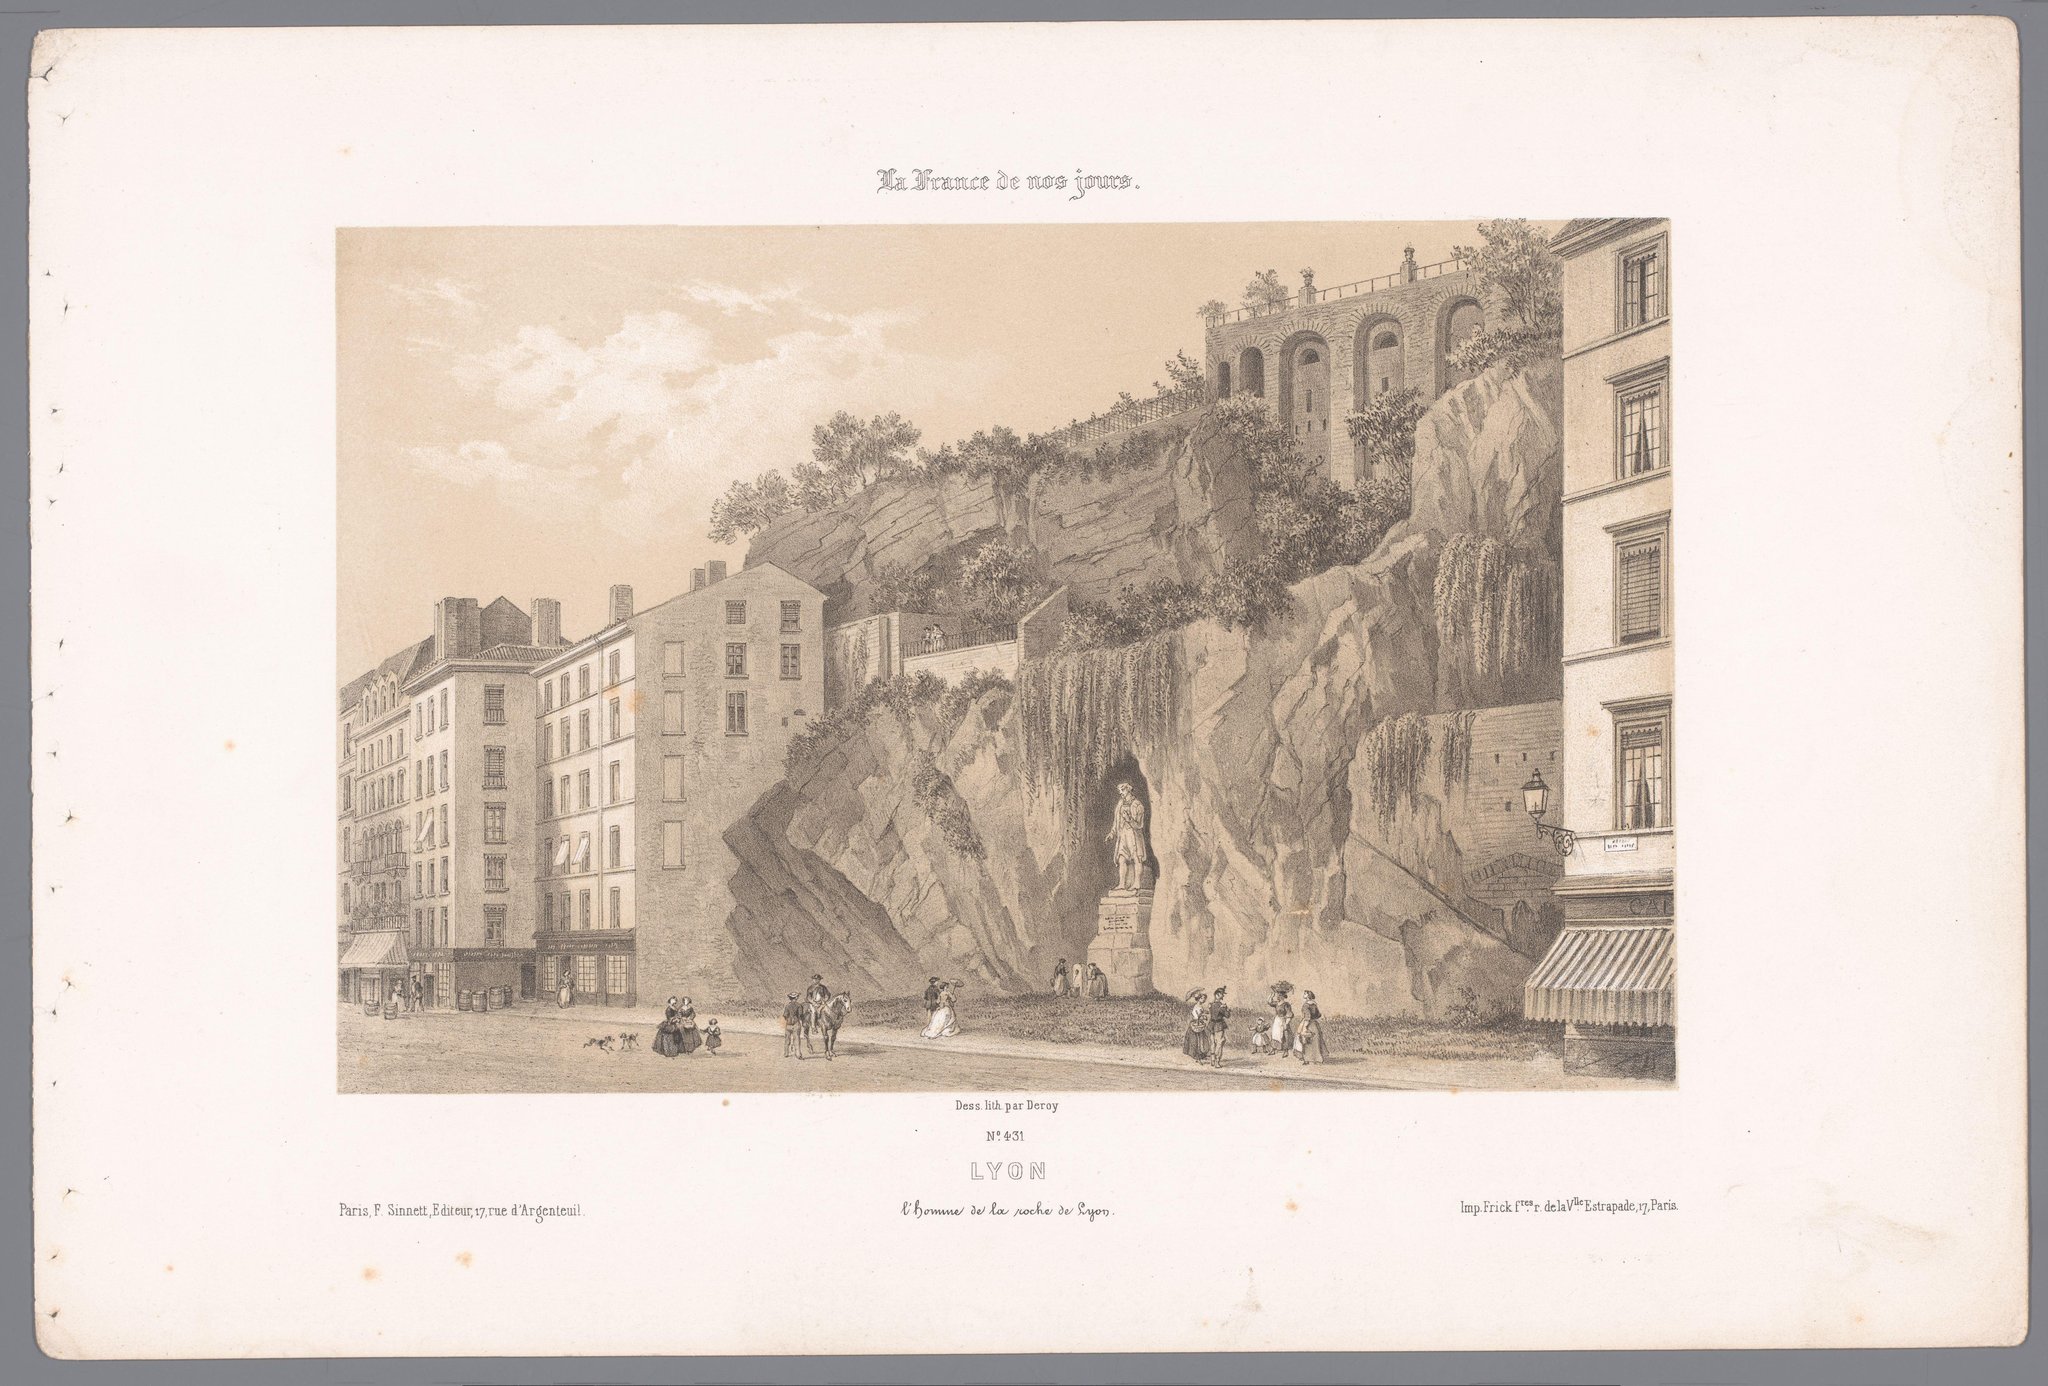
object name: print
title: Hedendaags Frankrijk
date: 1861-1872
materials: paper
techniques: tone lithography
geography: paris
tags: monument, statue, rocks (+ landscape with figures, staffage), lyon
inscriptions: collector's mark: Lugt 2228a